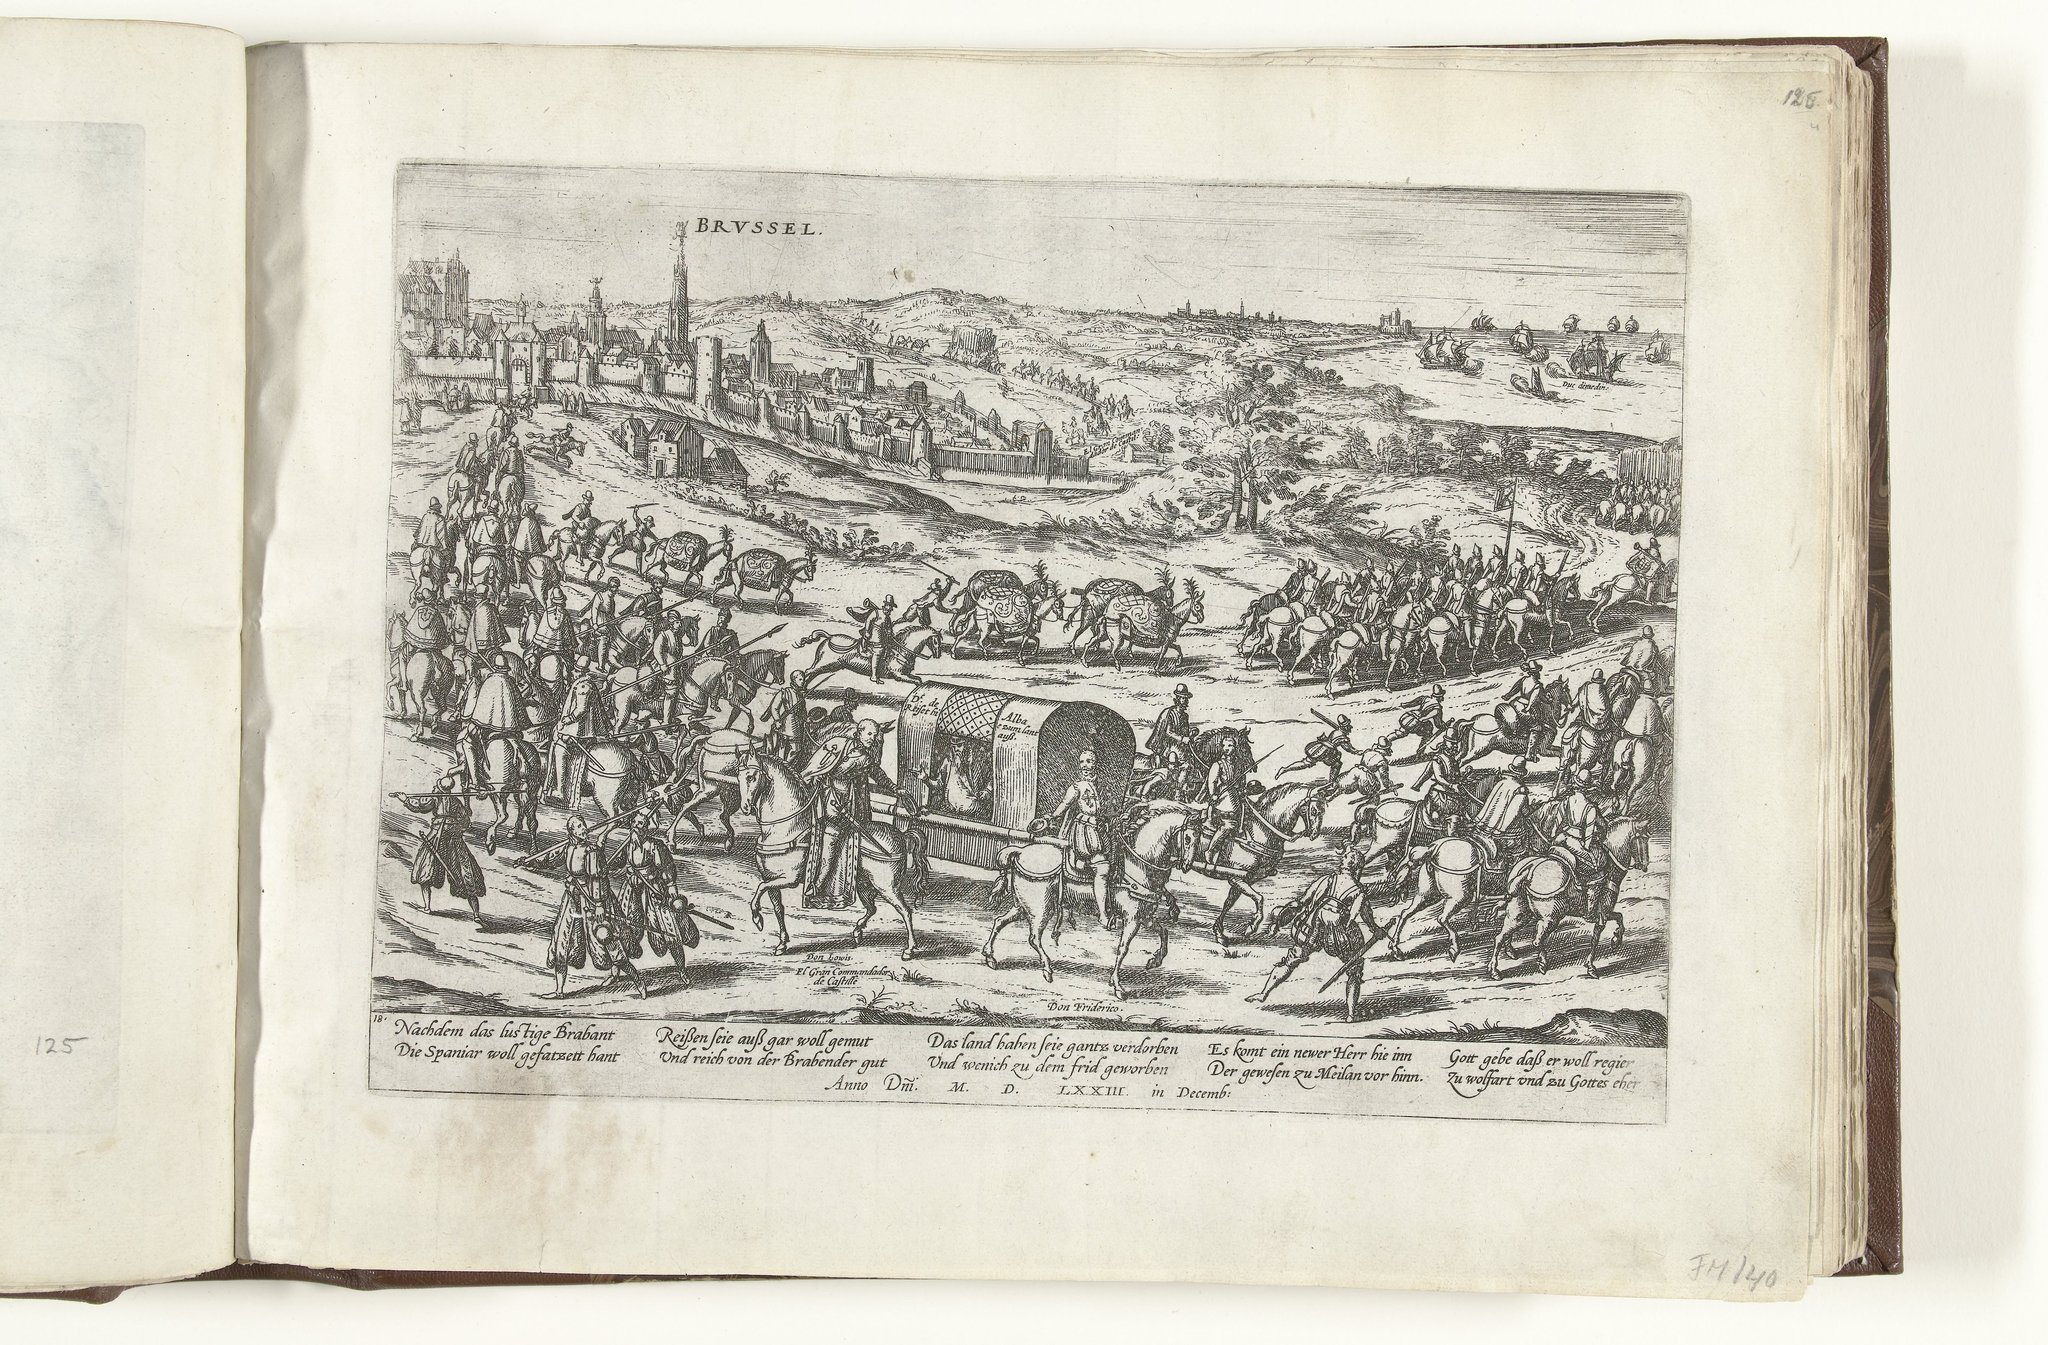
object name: print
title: Serie 6: Nederlandse Gebeurtenissen, 1571-1576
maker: frans hogenberg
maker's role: print maker, publisher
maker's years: 1538-1590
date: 1573-1575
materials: paper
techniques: etching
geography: cologne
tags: fernando álvarez de toledo (3rd duke of alba), brussels, luis de zúñiga y requesens, (carrying a person in a) sedan-chair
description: Alva verlaat de Nederlanden, december 1573. In een grote stoet vertrekt de hertog in een draagstoel uit Brussel naar Spanje. Hij groet de nieuwe landvoogd Requesens die richting Brussel rijdt. Met onderschrift van 10 regels in het Duits. Genummerd: 18.